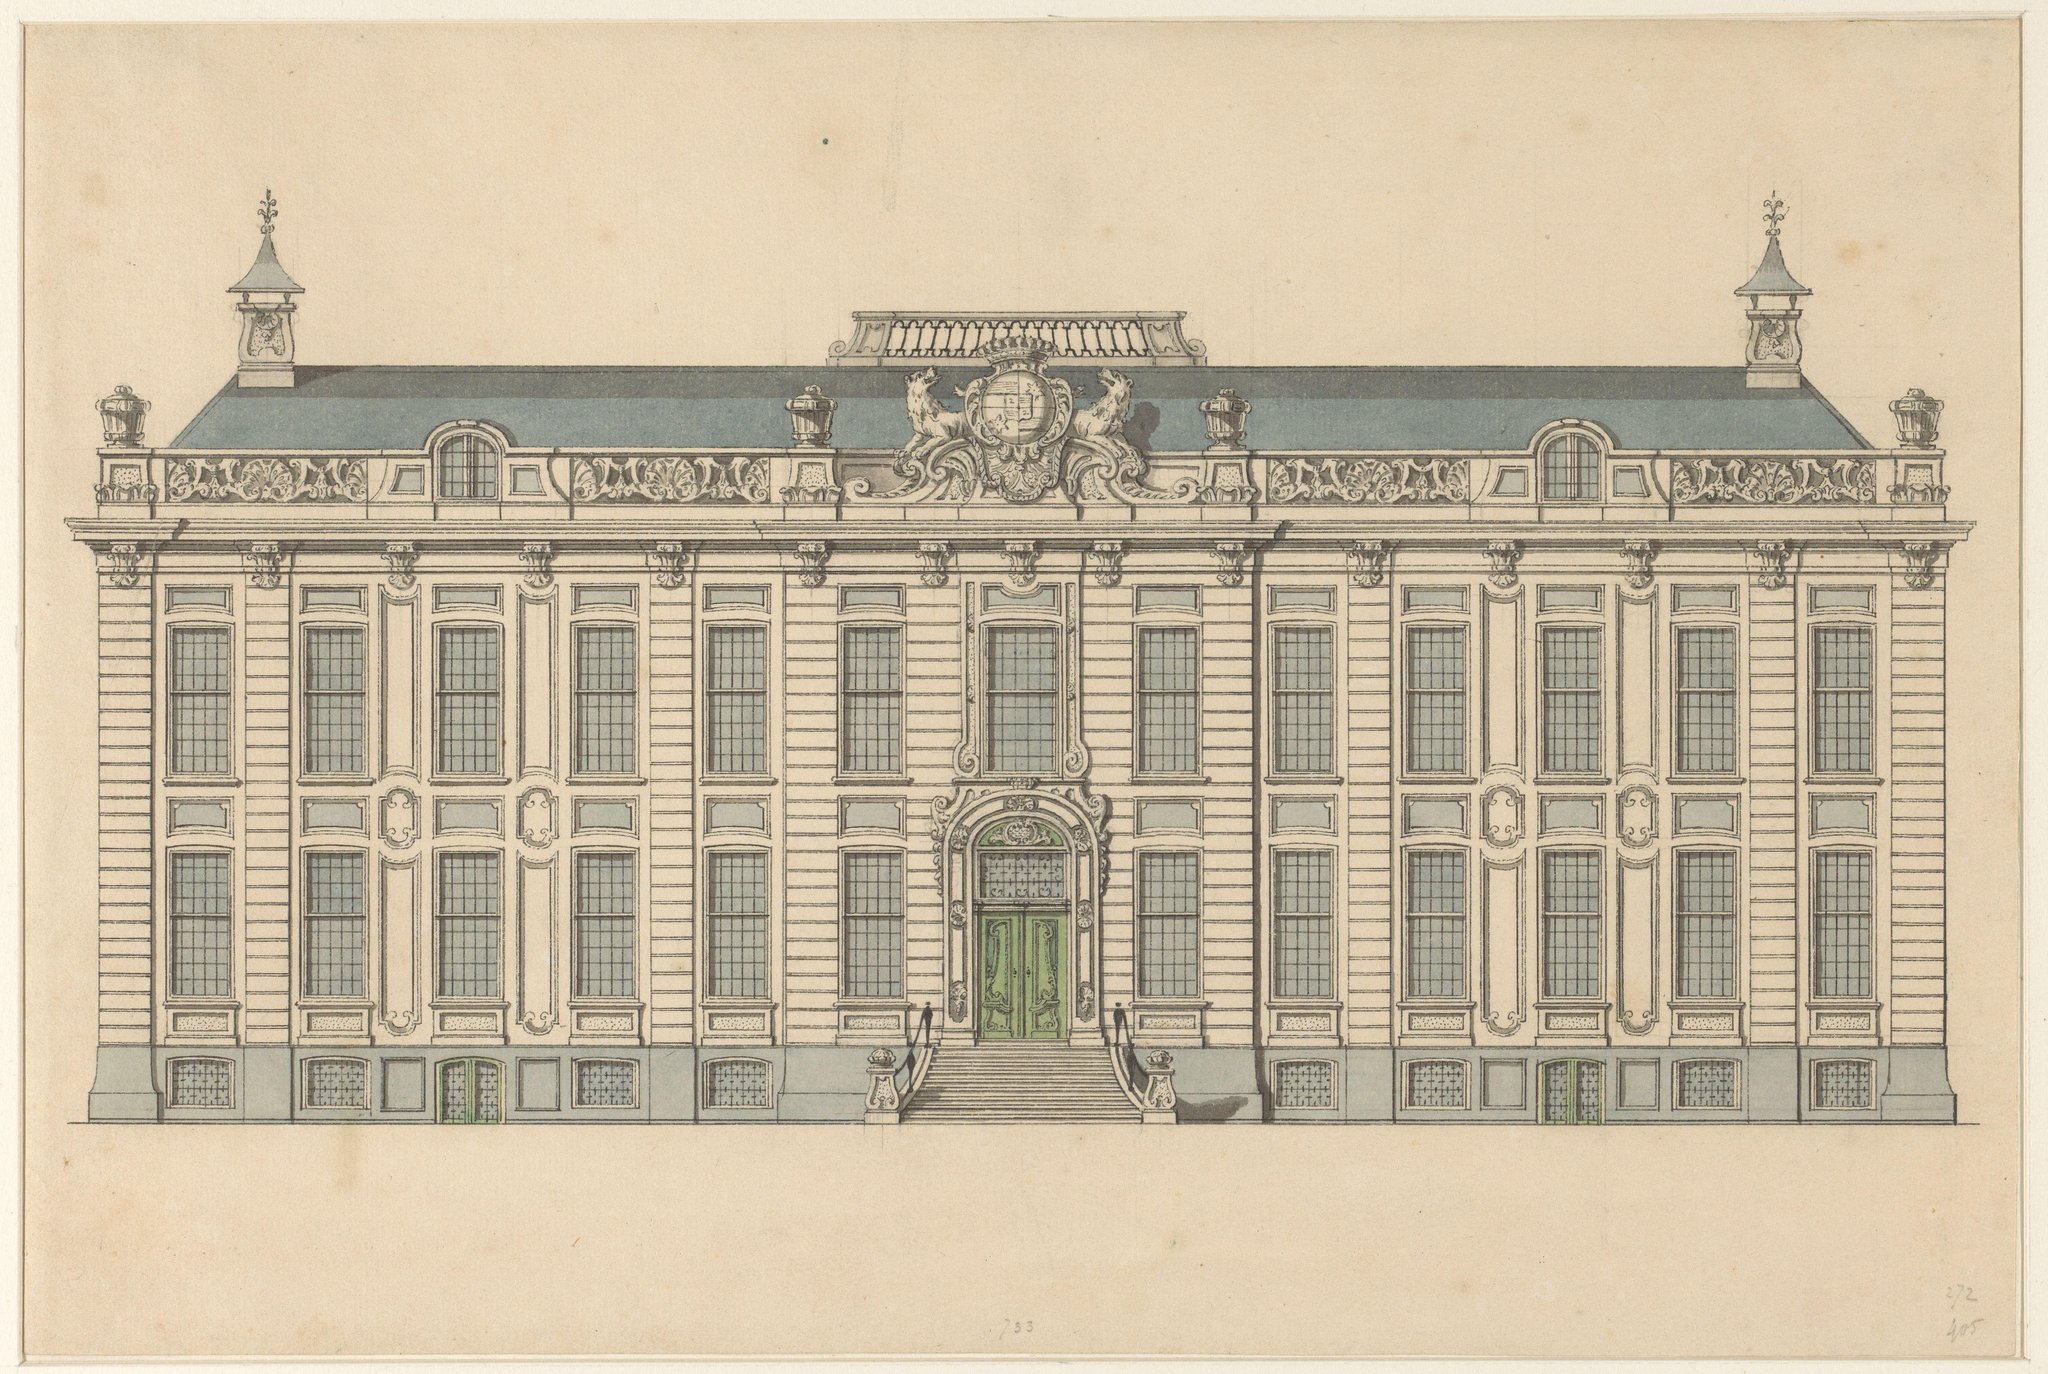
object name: drawing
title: Voorgevel van een paleis, mogelijk Huis Huguetan aan het Lange Voorhout te 's-Gravenhage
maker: Anonymous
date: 1725-1775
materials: ink, paper, pencil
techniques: brush, pen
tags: palace, façade (of house or building), exterior ~ architectural design or model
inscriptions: collector's mark: Lugt 2228, number: ‘733/ 272/ 405’